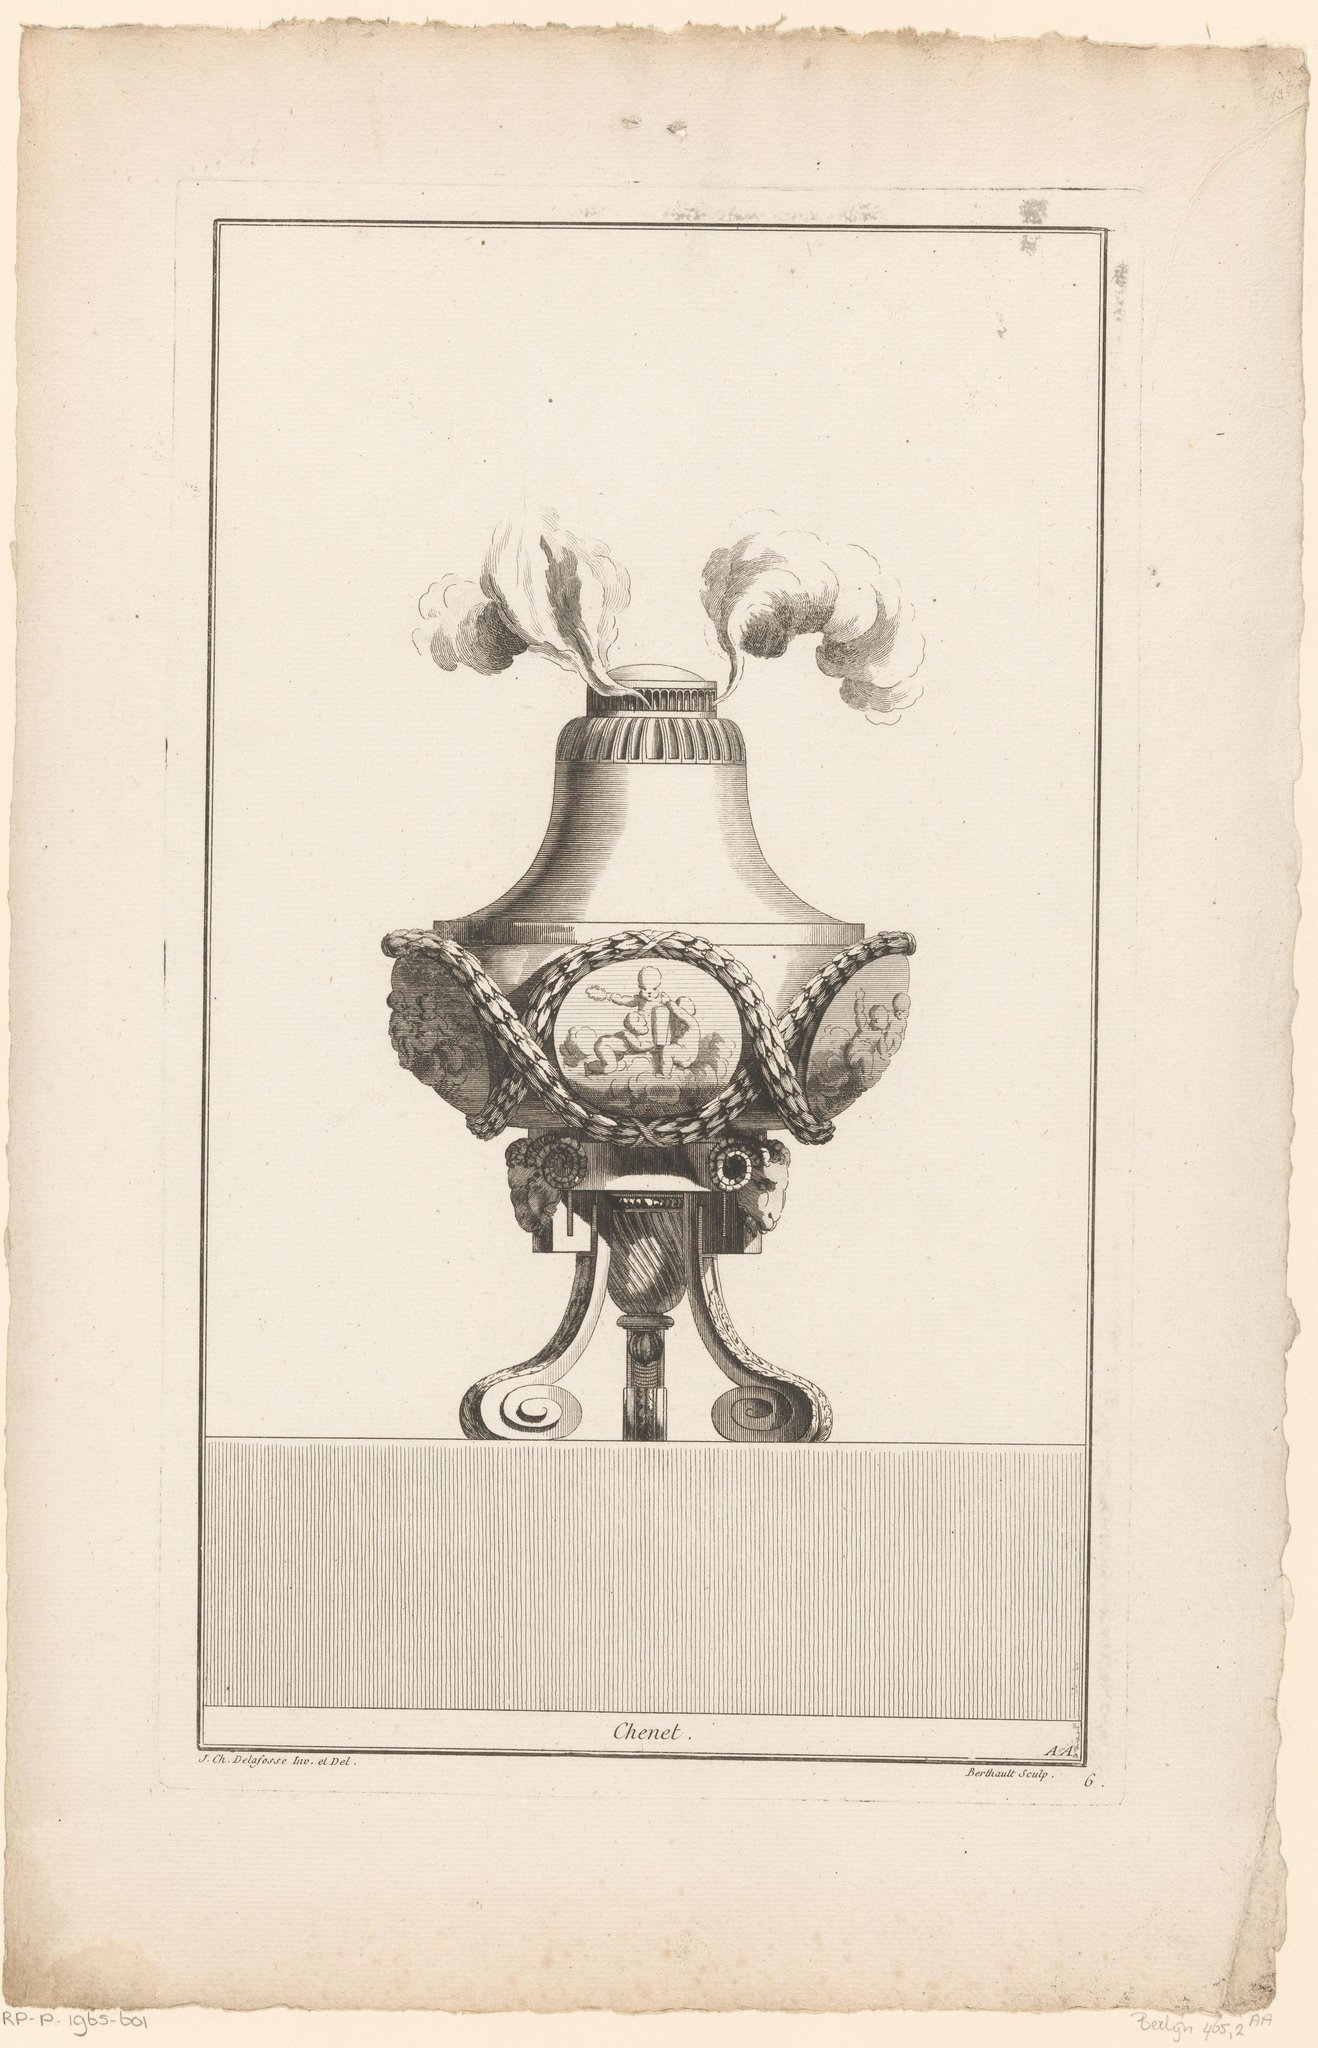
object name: print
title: 25e Cahier AA Cahier de 6 Grilles de Chenets et de Feux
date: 1771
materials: paper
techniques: engraving, etching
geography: paris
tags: andiron, fire-dog, incense-burner ~ scents, perfumes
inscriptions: collector's mark: Lugt 2228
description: Een geornamenteerde vuurbok in de vorm van een rookvat met medaillons met putti en ramskoppen.